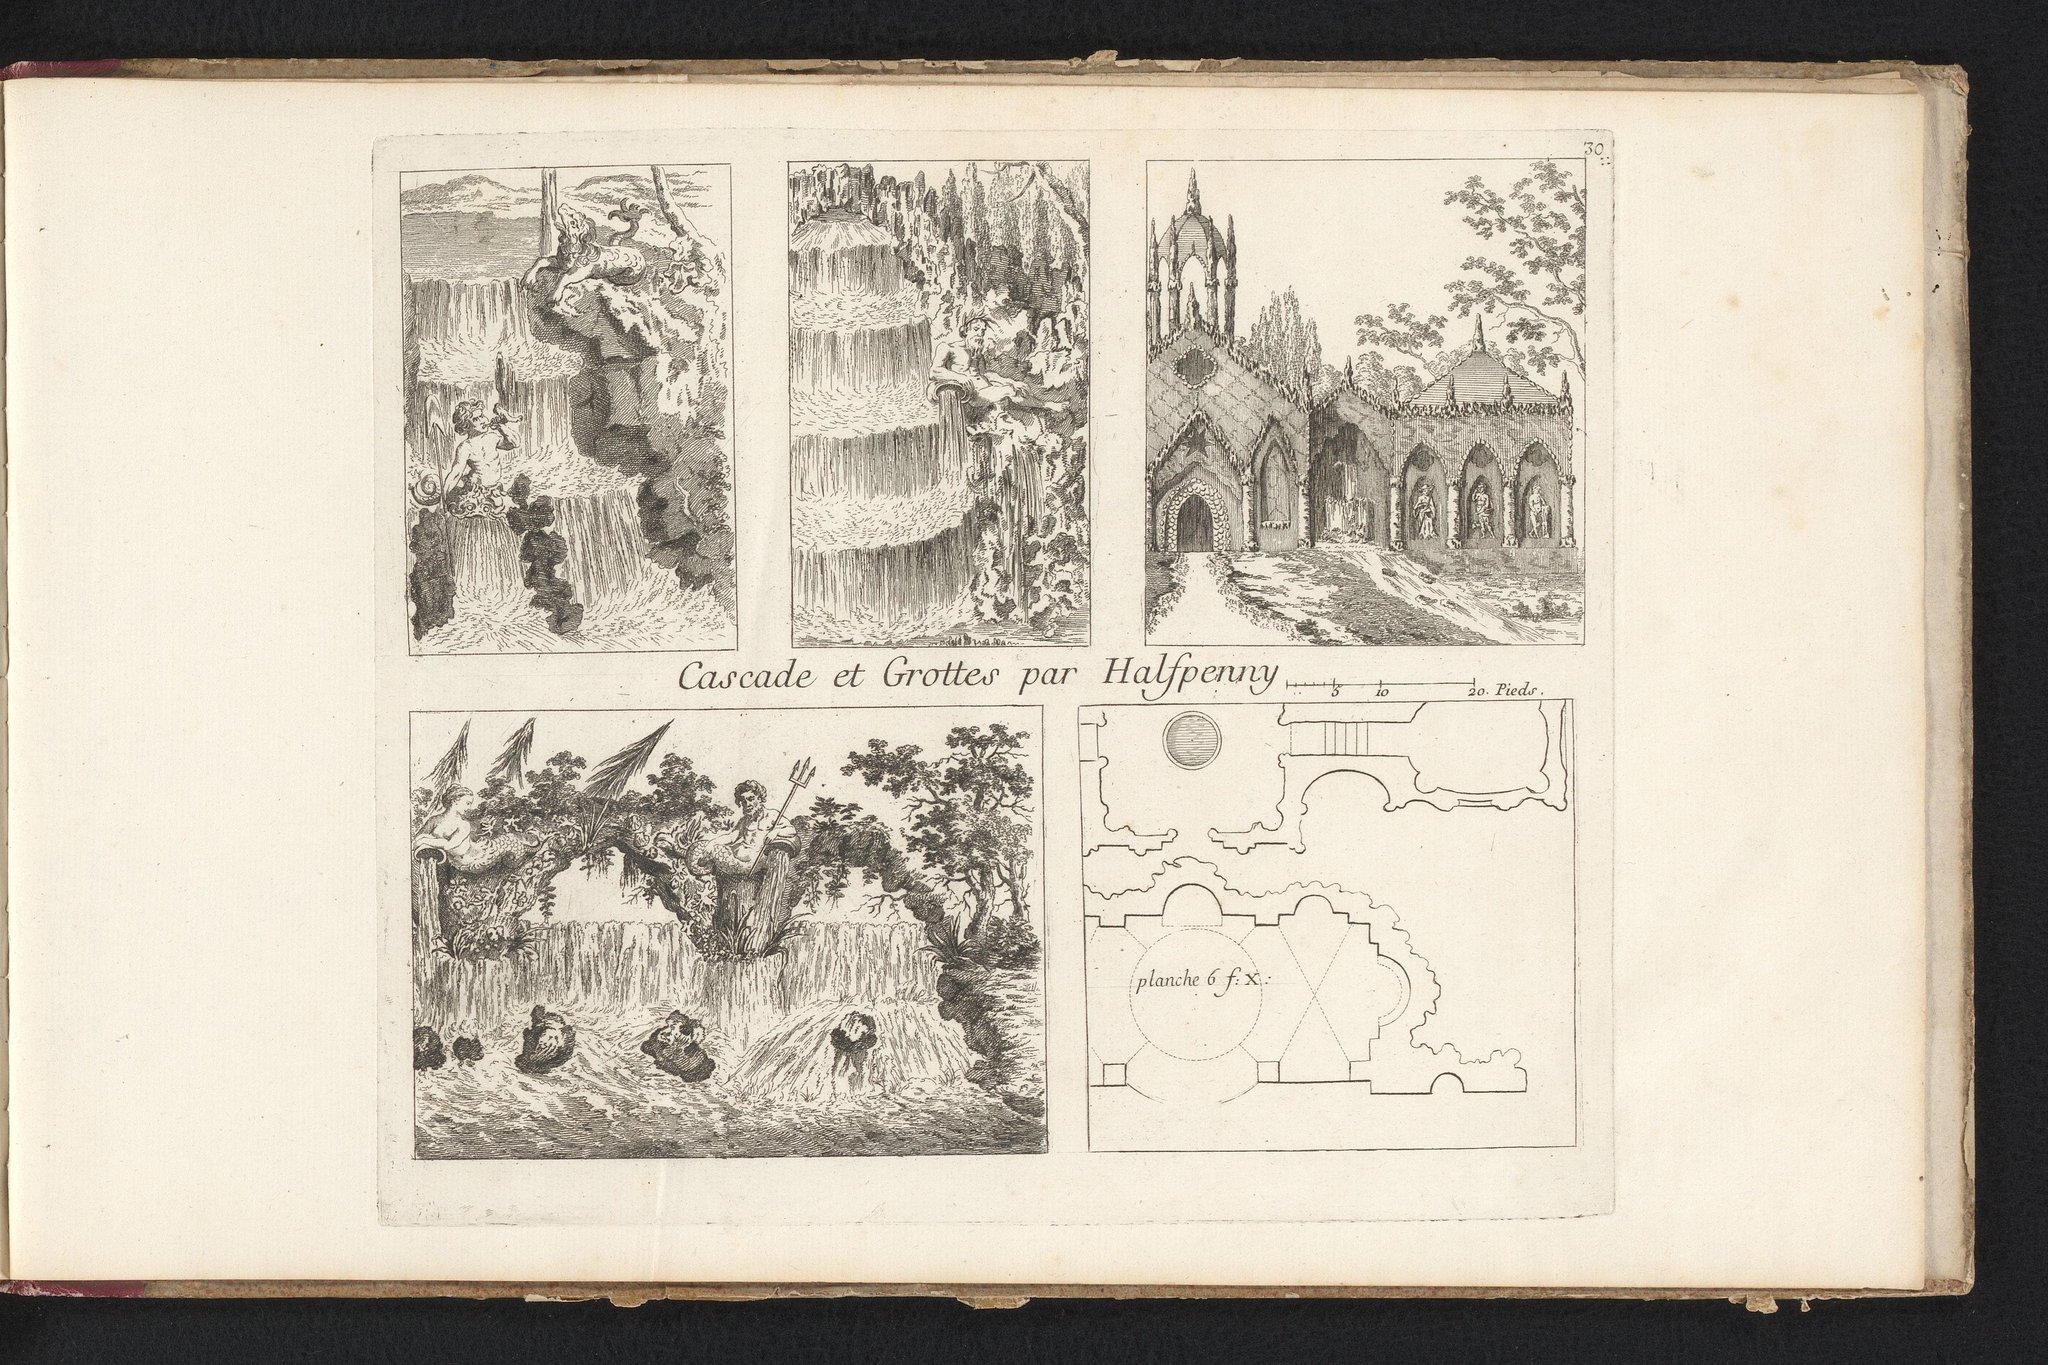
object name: album leaf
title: Landschapstuinen in Chinees-Engelse stijl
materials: paper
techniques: engraving, etching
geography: paris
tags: garden buildings, garden cascade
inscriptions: collector's mark: Lugt 2760, collector's mark: Lugt 2228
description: De serie 'Jardins anglo-chinois à la mode' verscheen in totaal in 21 zogeheten 'cahiers' (afleveringen). De huidige prent komt uit het vierde 'cahier'. Het Rijksmuseum Amsterdam bezit drie banden met daarin in totaal zes 'cahiers' van deze reeks. In de documentatie wordt verwezen naar een in de bibliotheek van het Rijksmuseum Amsterdam aanwezige facsimile van het complete werk.